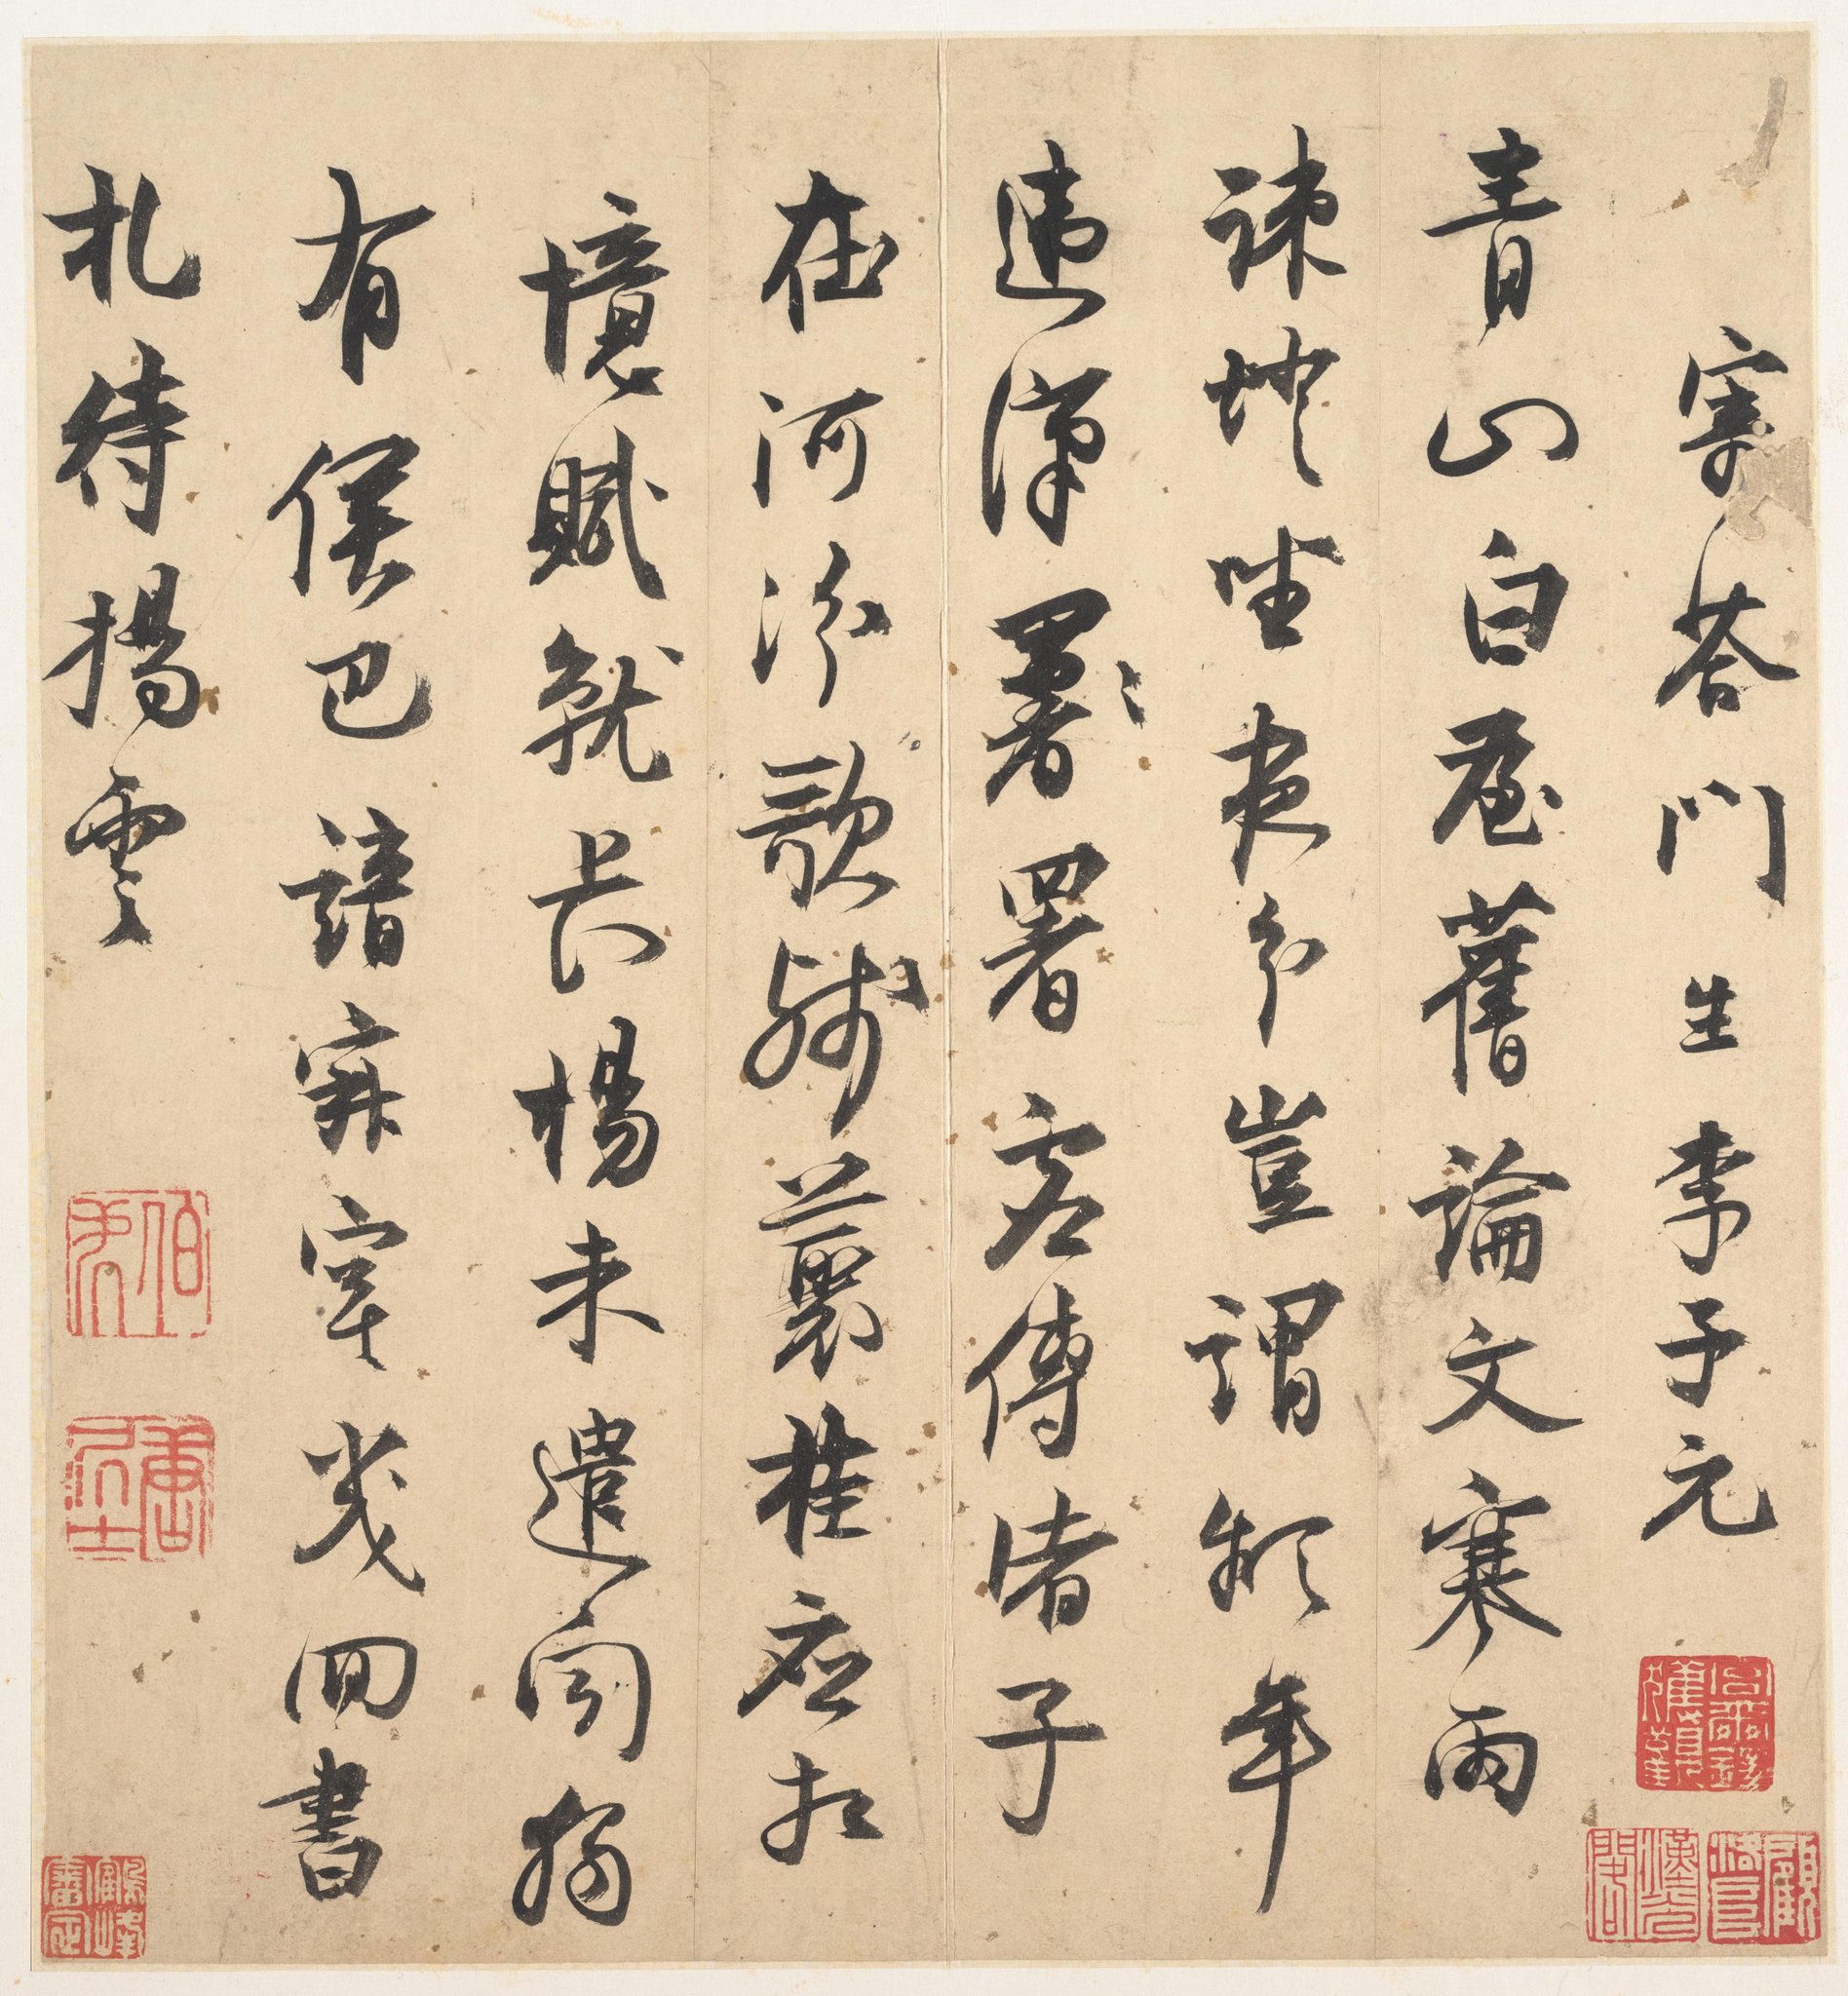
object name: album leaf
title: Letter to Li Ziyuan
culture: chinese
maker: tang yin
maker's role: artist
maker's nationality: chinese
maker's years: 1470-1524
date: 1470-1524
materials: ink, paper